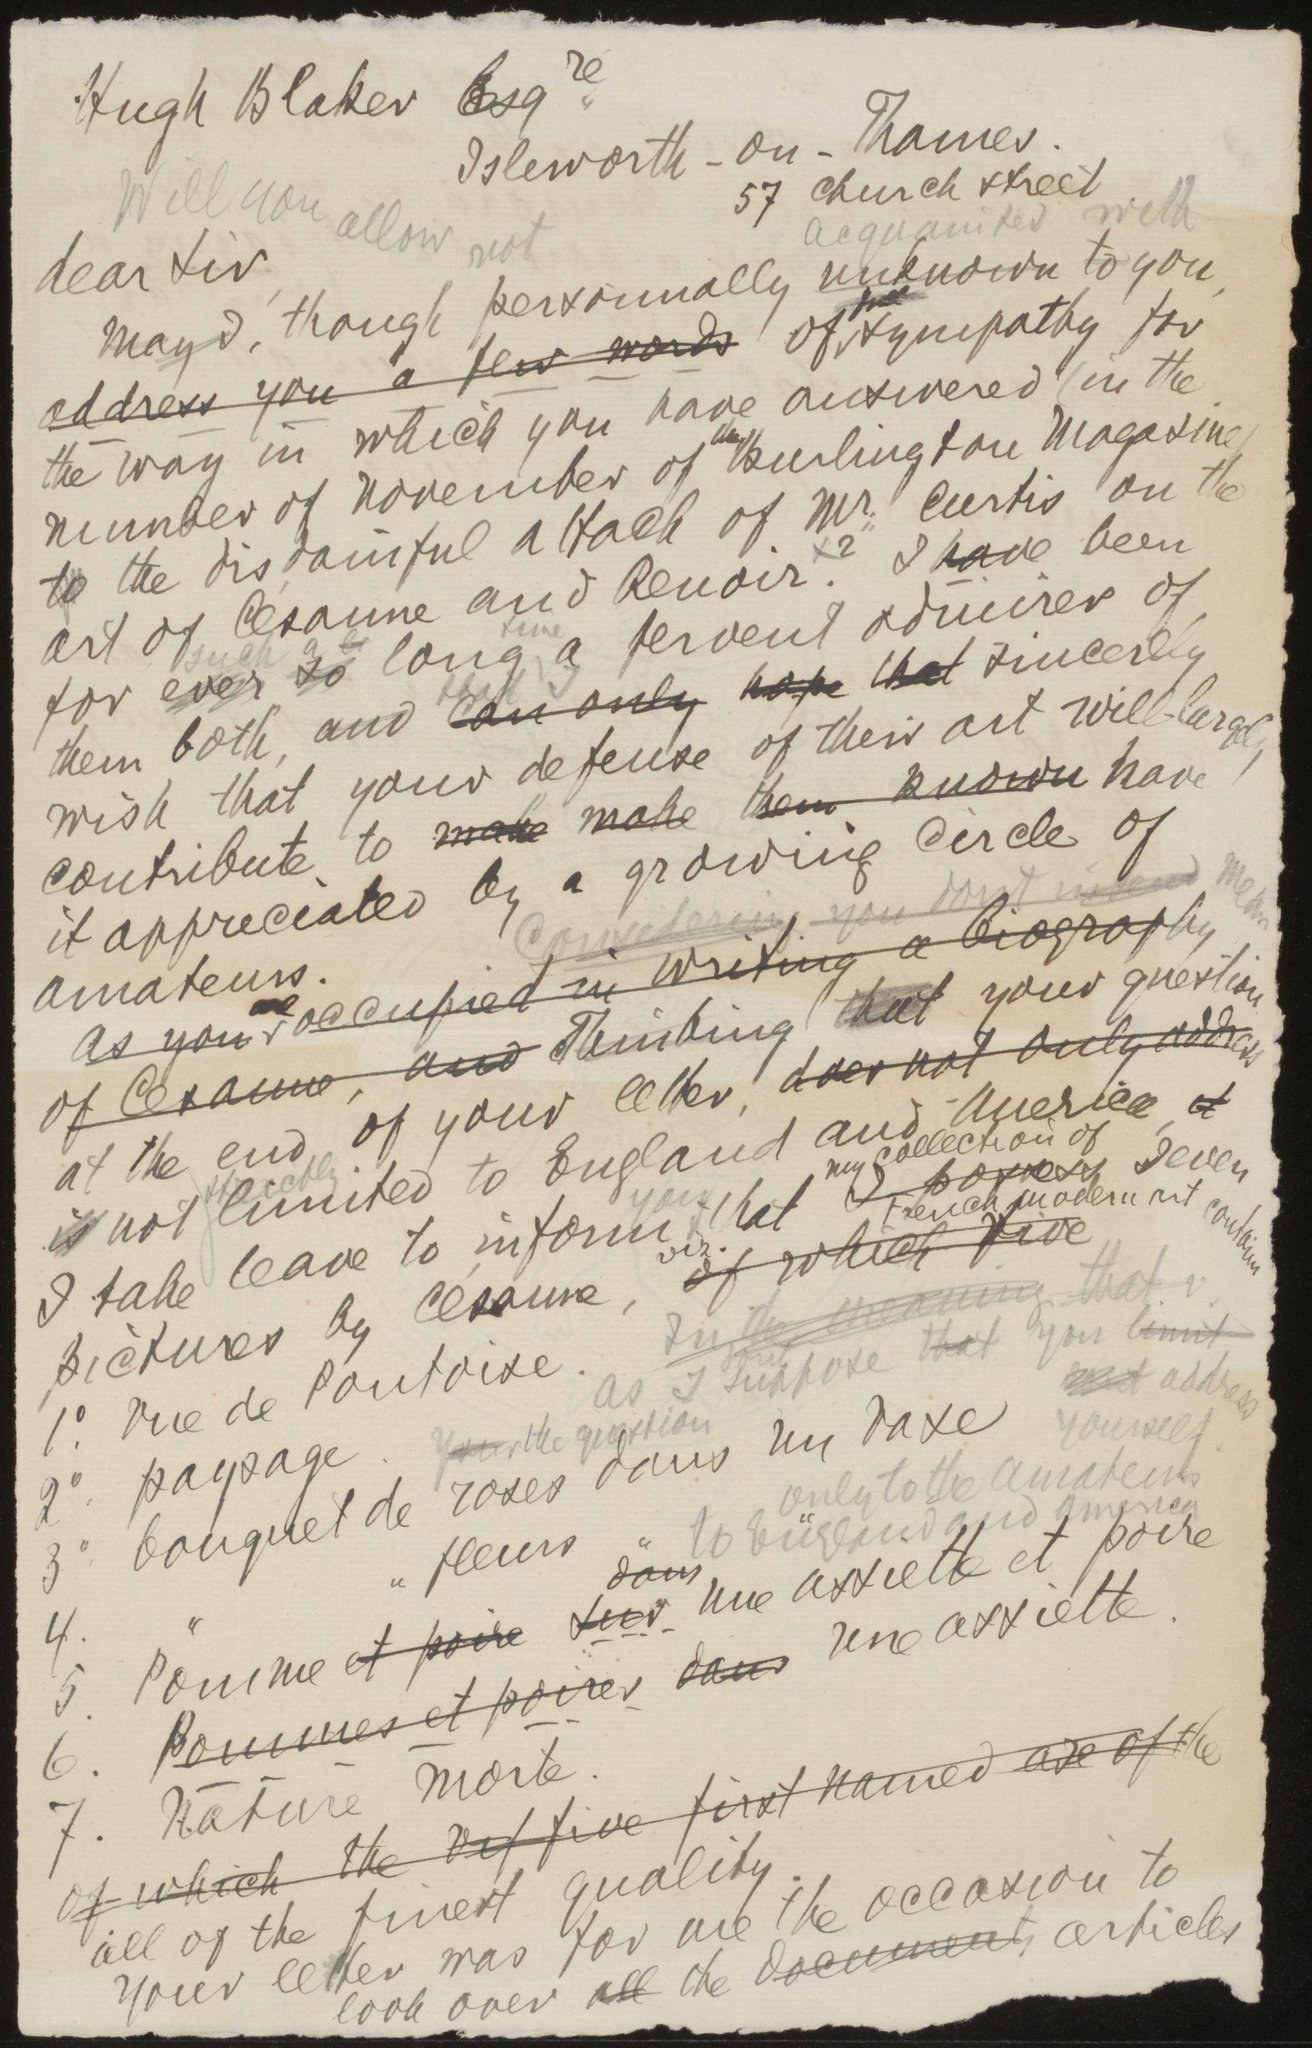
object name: letter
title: Conceptbrief aan Hugh Blaker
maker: andries bonger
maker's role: kunstverzamelaar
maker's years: 1861-1936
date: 1917-1918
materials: ink, paper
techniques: pen, writing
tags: hugh blaker, painter, draughtsman, odilon redon, lille, paris, print maker, émile bernard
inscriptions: watermark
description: De conceptbrief betreft een reactie op een dispuut over Paul Cézanne in The Burlington Magazine. De conceptbrief bevat de betreffende artikelen (uit november 1917 en oktober 1918) overgeschreven door Andries Bonger.